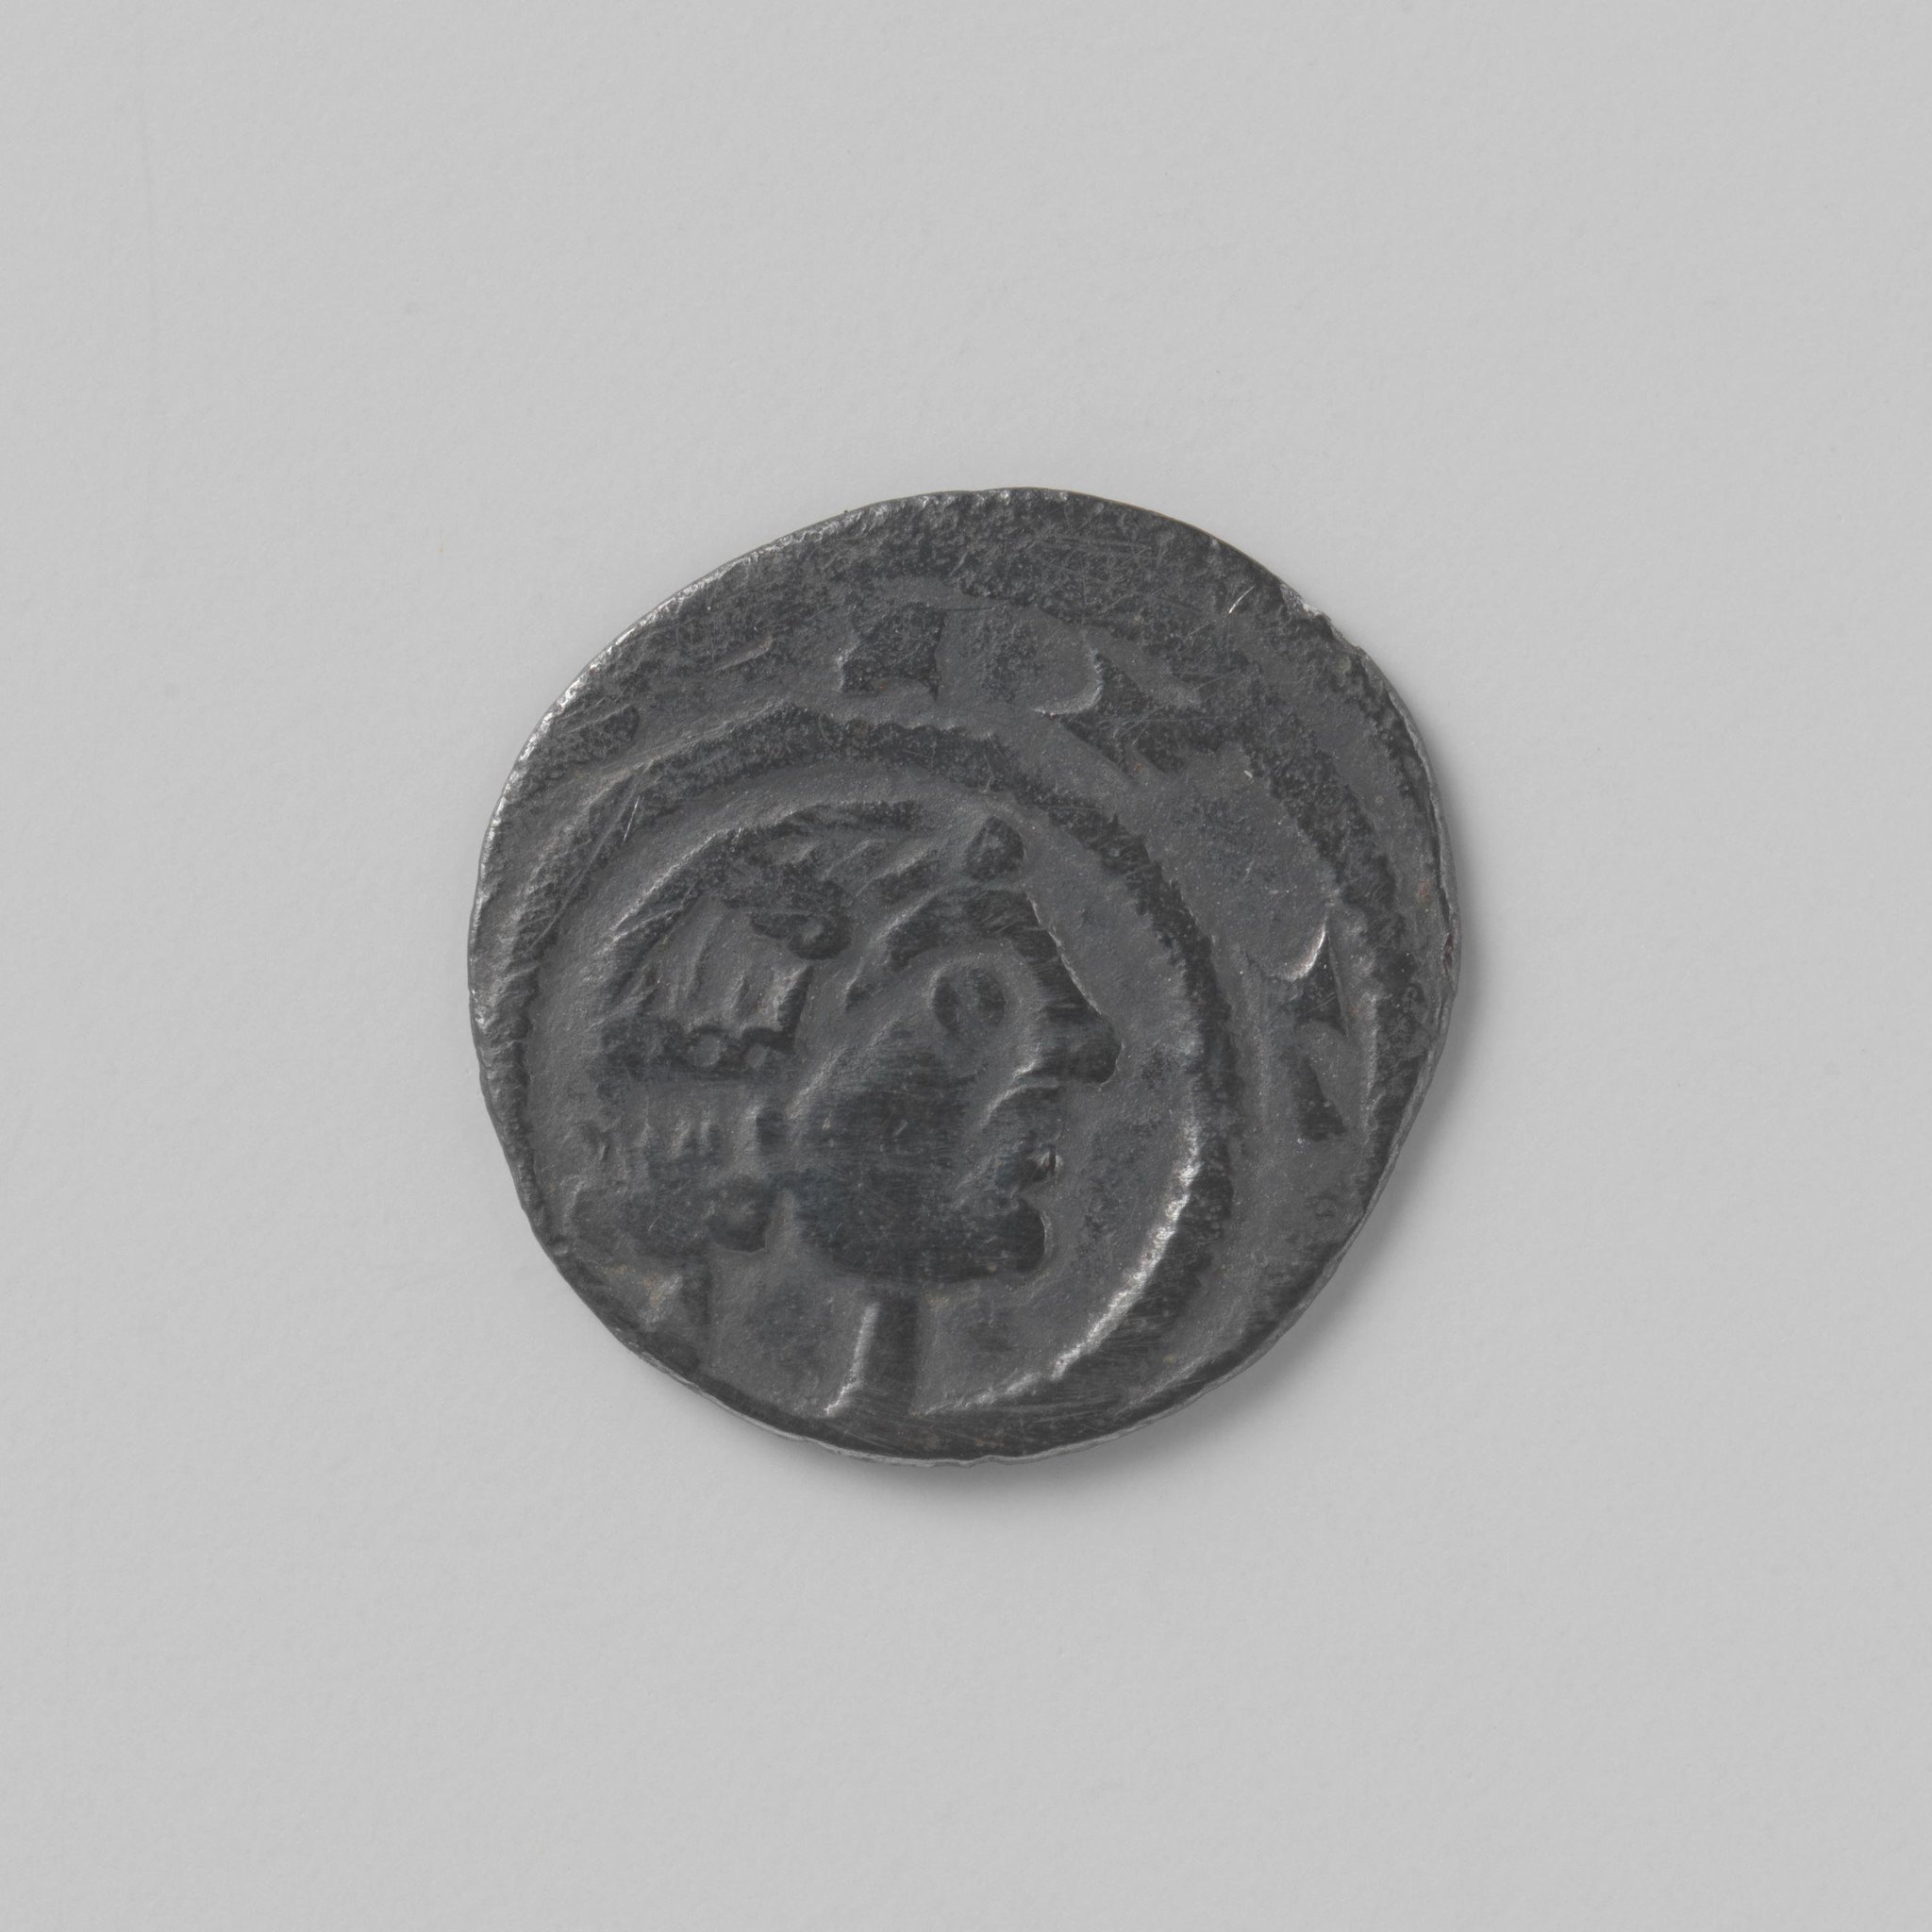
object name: coin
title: Hollandse penning van Floris IV, 1222-1234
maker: floris iv (graaf van holland)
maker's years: 1210-1234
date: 1222-1234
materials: silver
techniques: striking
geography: dordrecht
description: Zilveren munt. Voorzijde: hoofd met gravenmuts naar rechts. Keerzijde: kort dubbellijnig kruis.